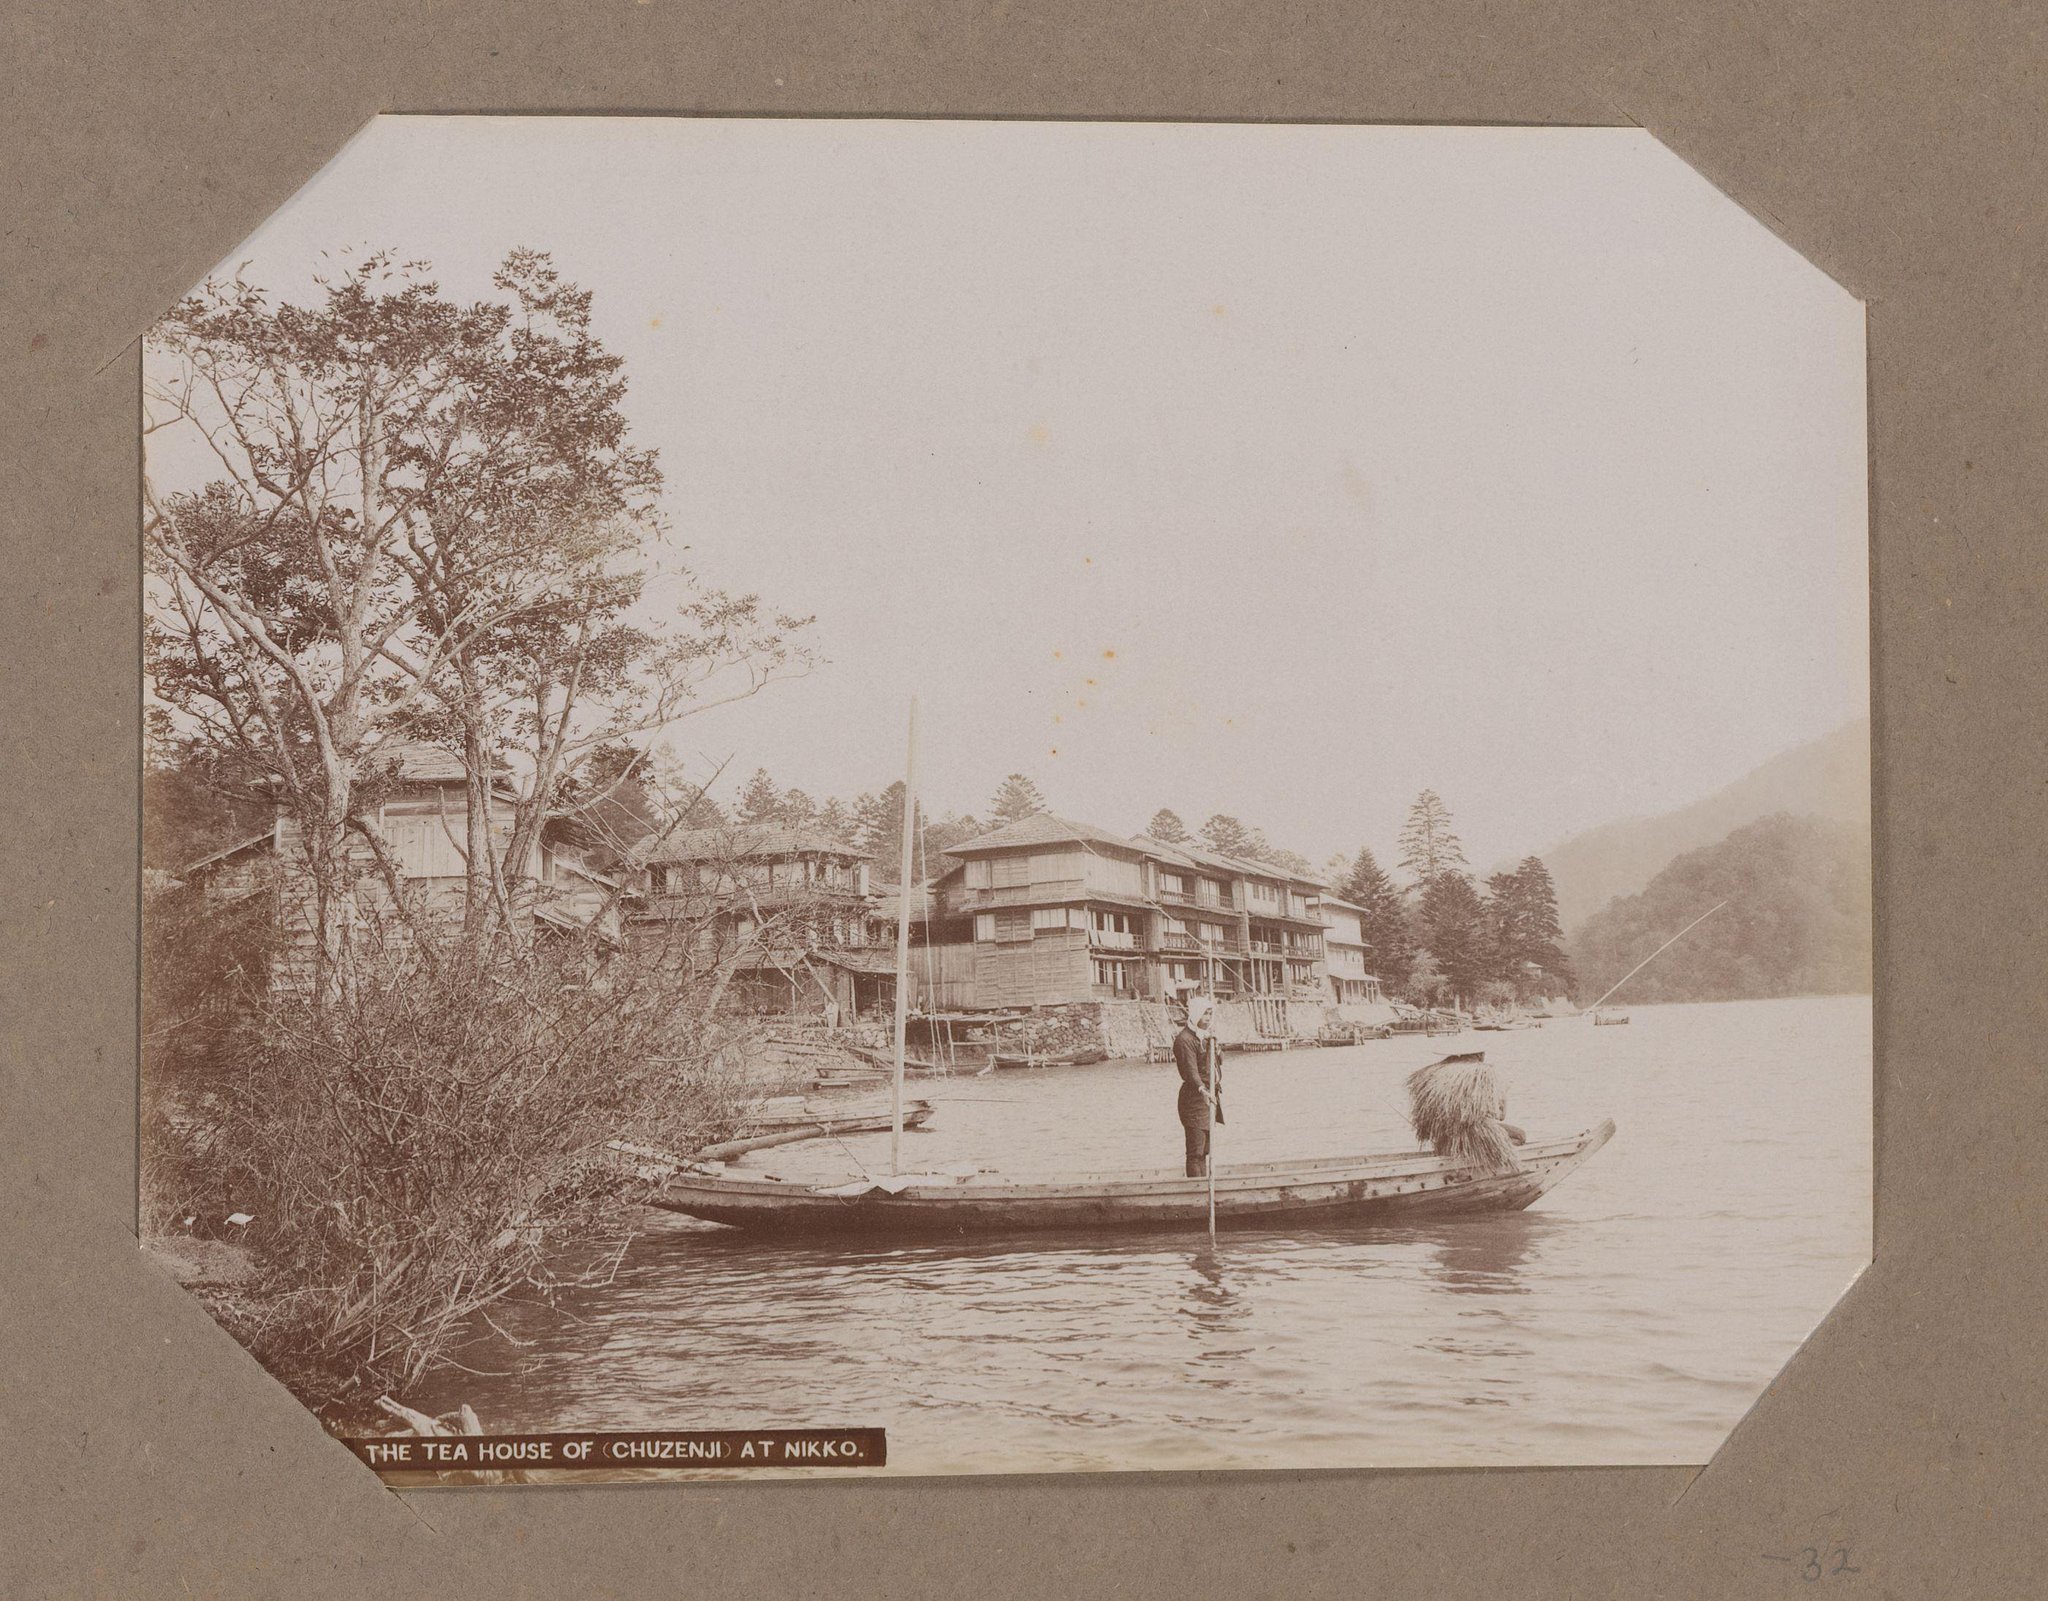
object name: photograph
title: Theehuis aan het Chozenji-ko meer bij Nikko, Japan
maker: Anonymous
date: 1890-1903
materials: paper, photographic support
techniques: albumen print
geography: japan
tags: lake, tea garden, garden restaurant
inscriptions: inscription: ‘J 395 The Tea House of (Chuzenji) at Nikko’